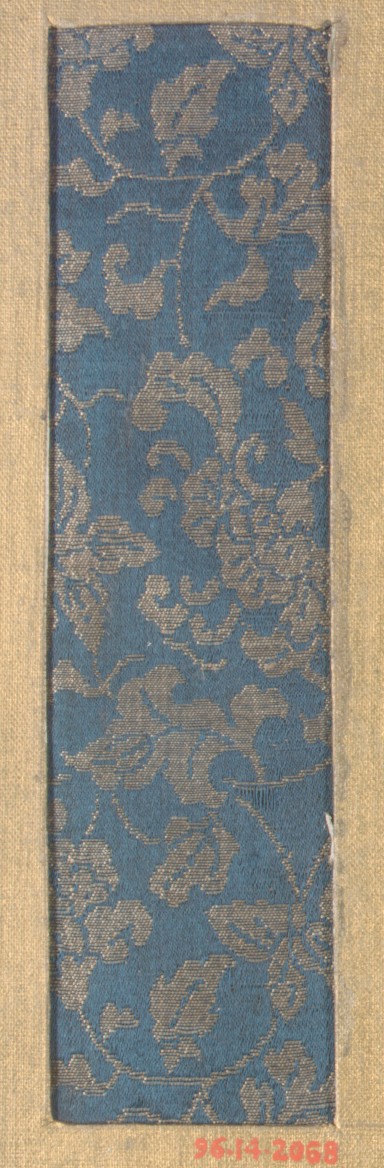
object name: piece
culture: japanese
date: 1701-1900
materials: silk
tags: flowers